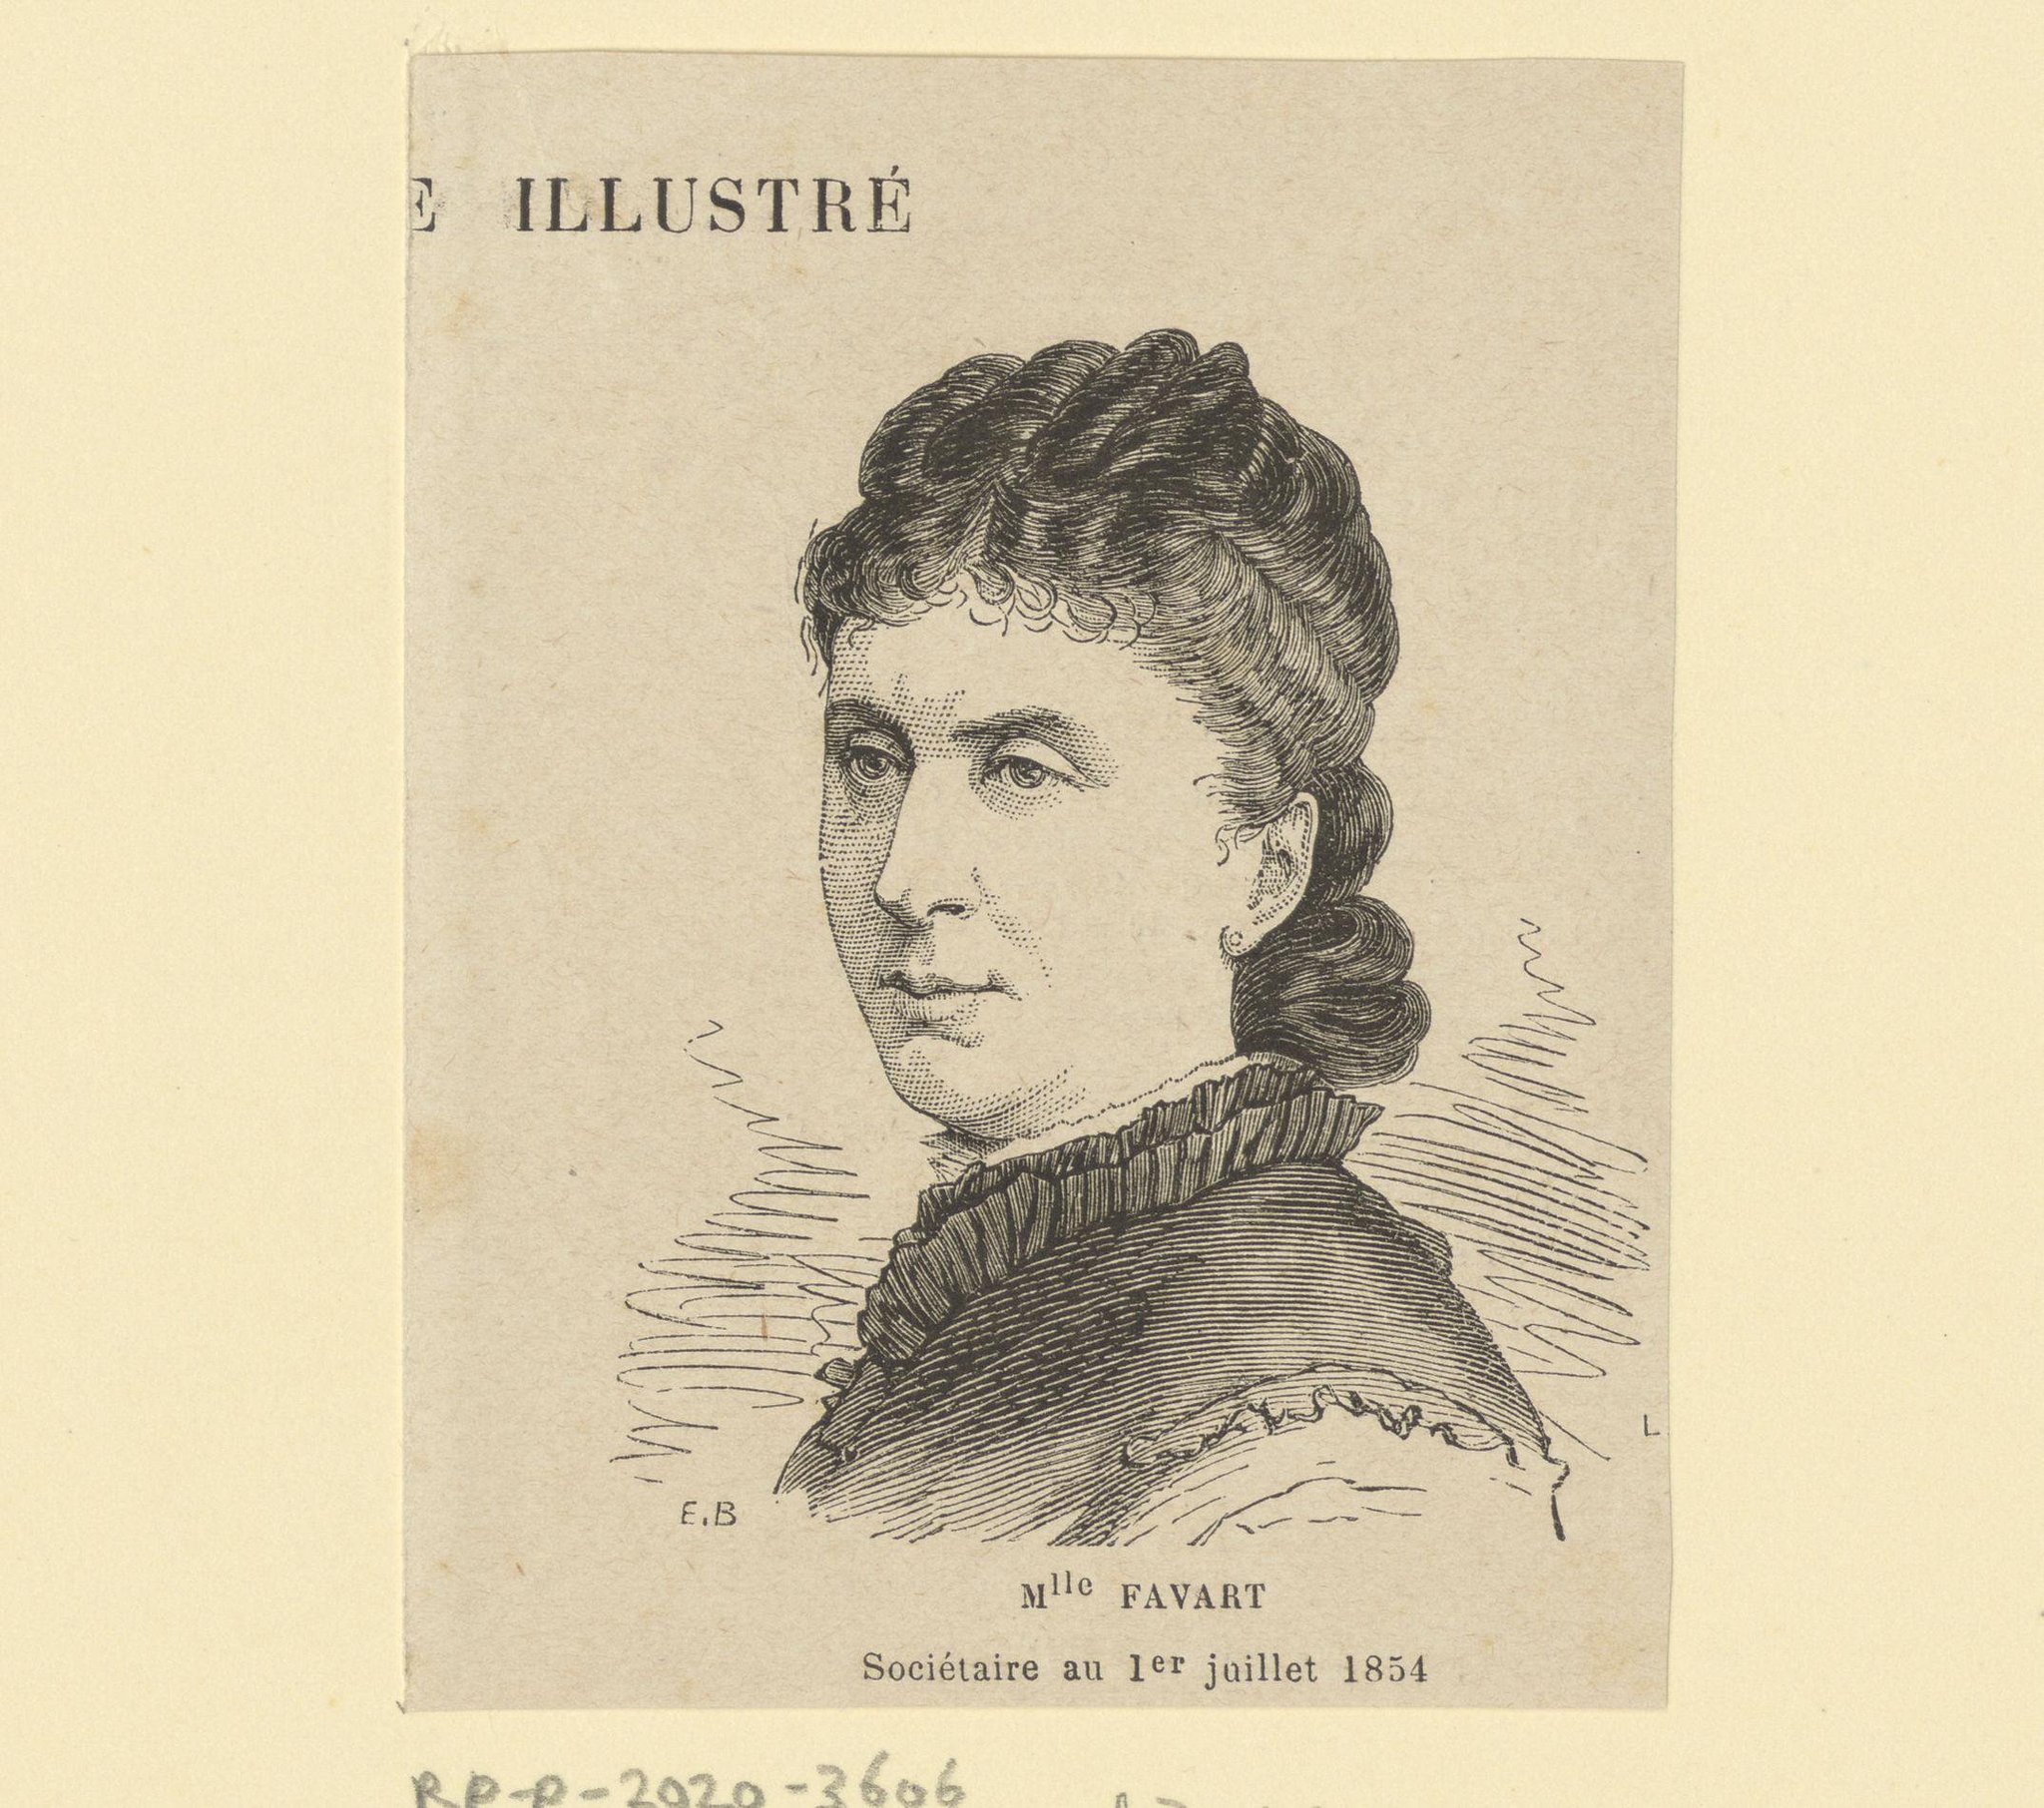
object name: print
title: Portret van Marie Favart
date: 1879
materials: paper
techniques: letterpress printing, engraving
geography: france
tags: paris, historical persons - bb - woman, portrait of actor, actress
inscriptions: monogram: ‘E.B.’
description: Prent uit: Le Monde Illustré 23 (1879), nr. 1163, 16 augustus 1879.